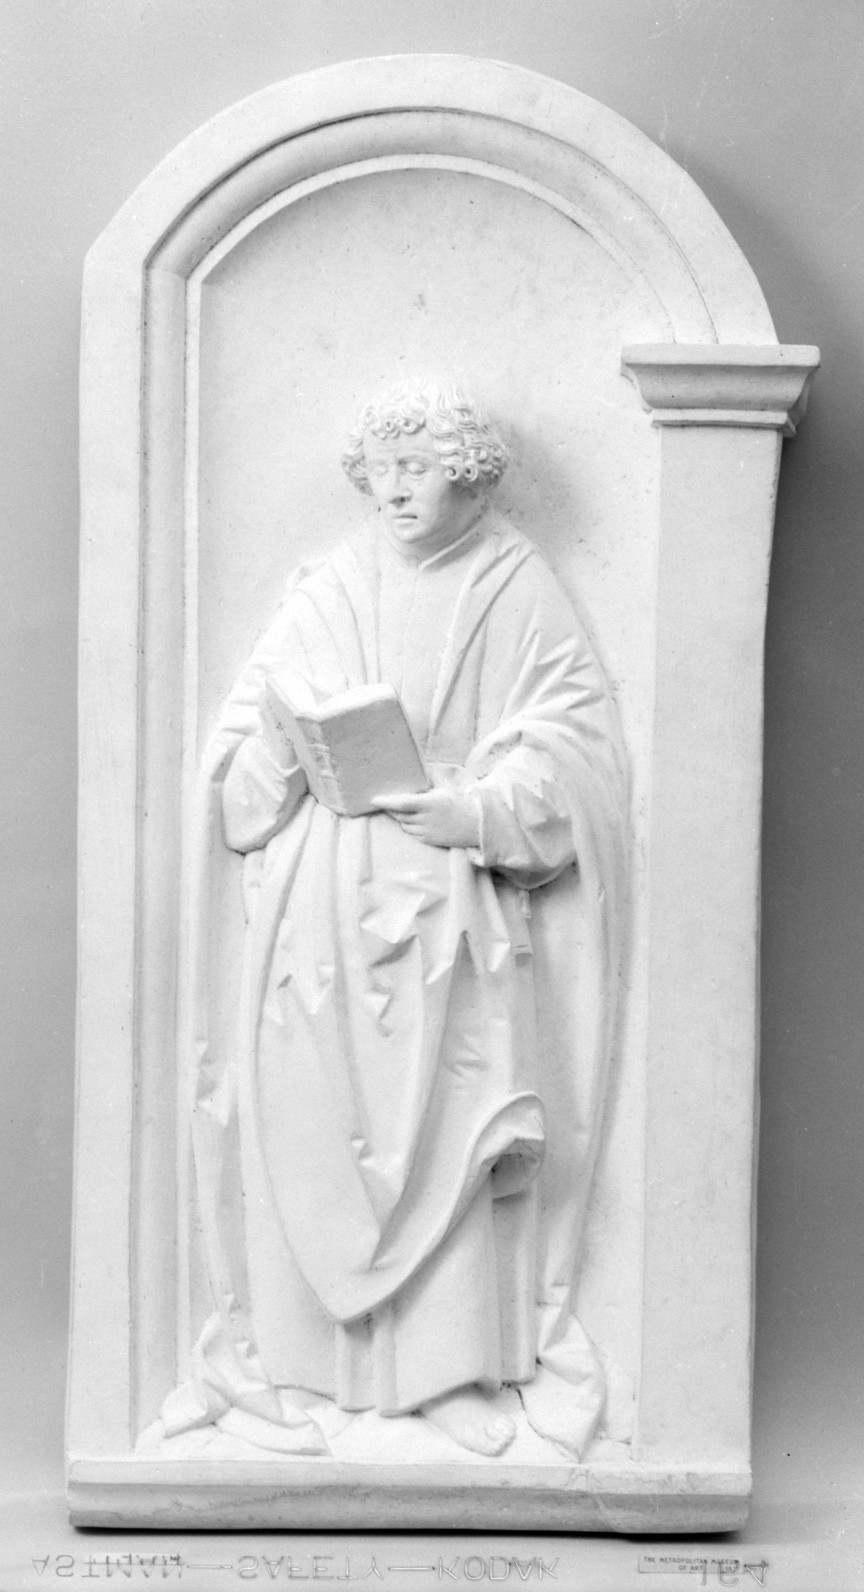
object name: relief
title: St. John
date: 1501-1600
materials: stone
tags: books,reading,saint john the baptist